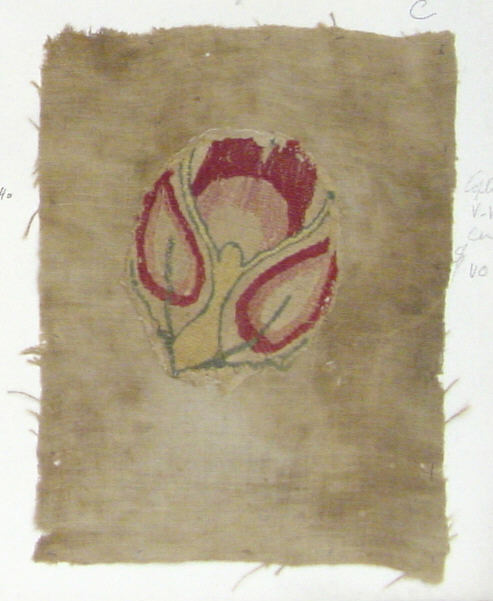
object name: textile fragment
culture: coptic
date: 401-600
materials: linen, wool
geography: egypt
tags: flowers